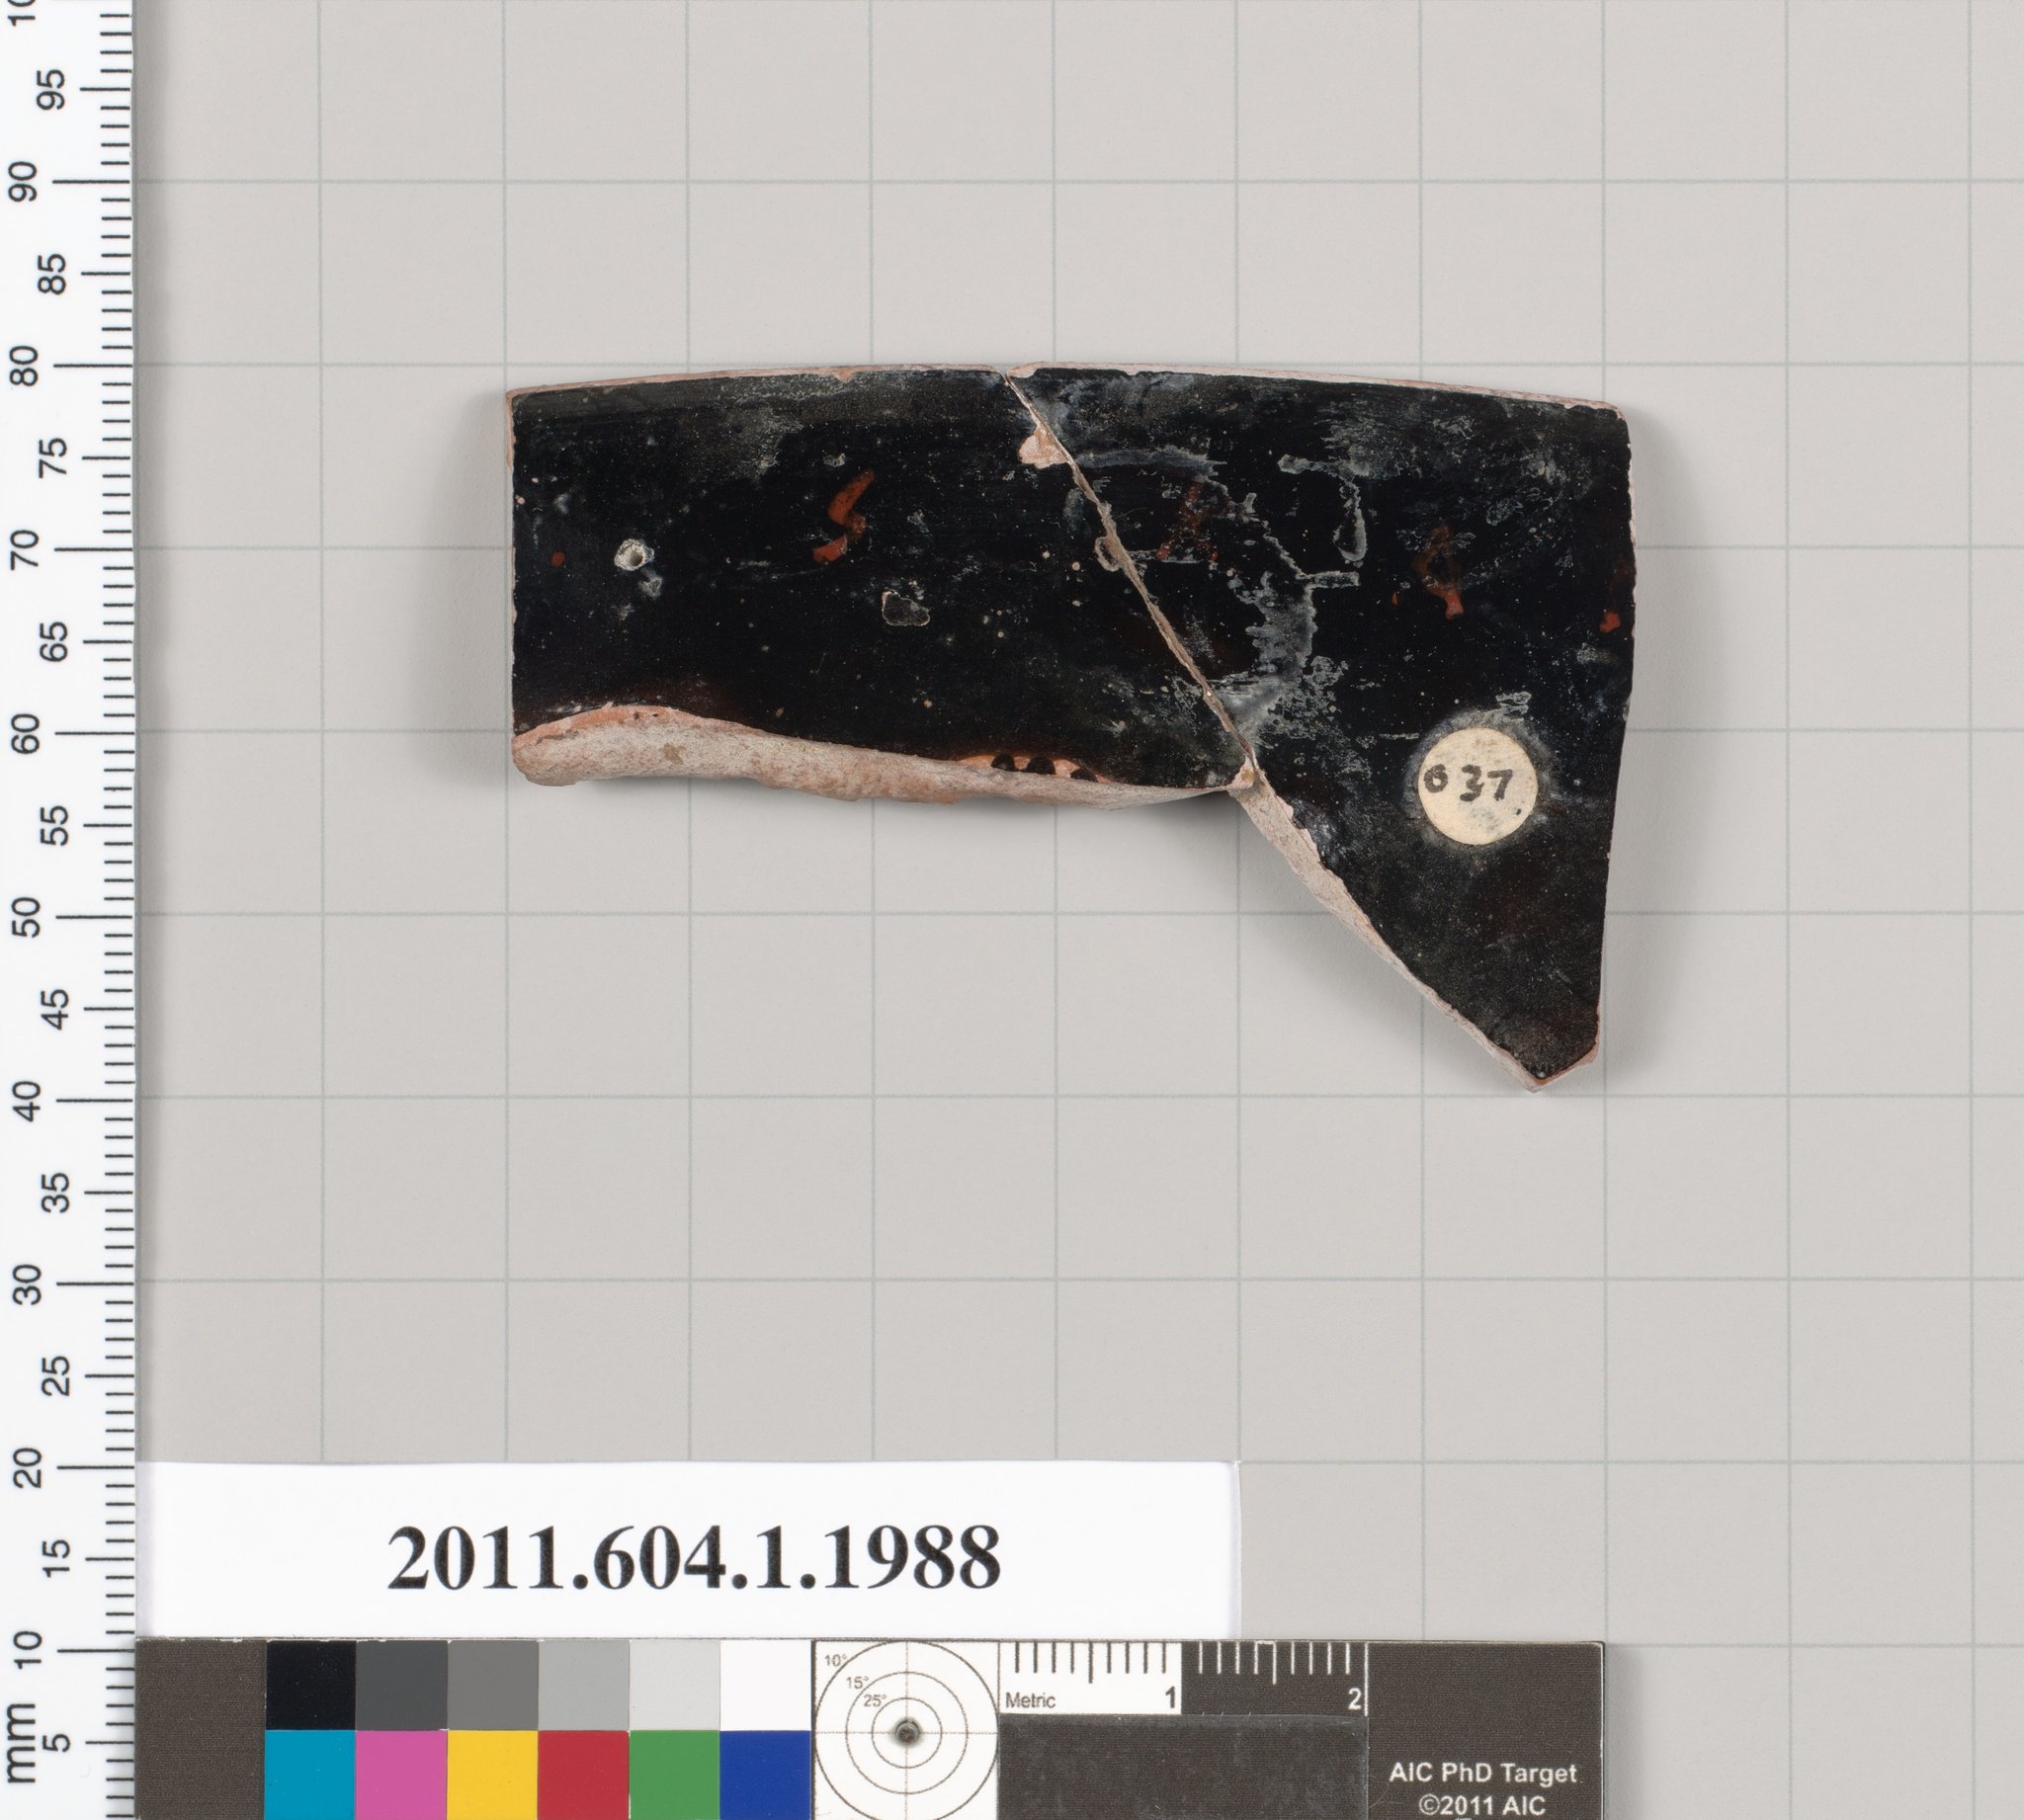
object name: kylix fragment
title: Terracotta rim fragment of a kylix (drinking cup)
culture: greek, attic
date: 500-401 BCE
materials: terracotta